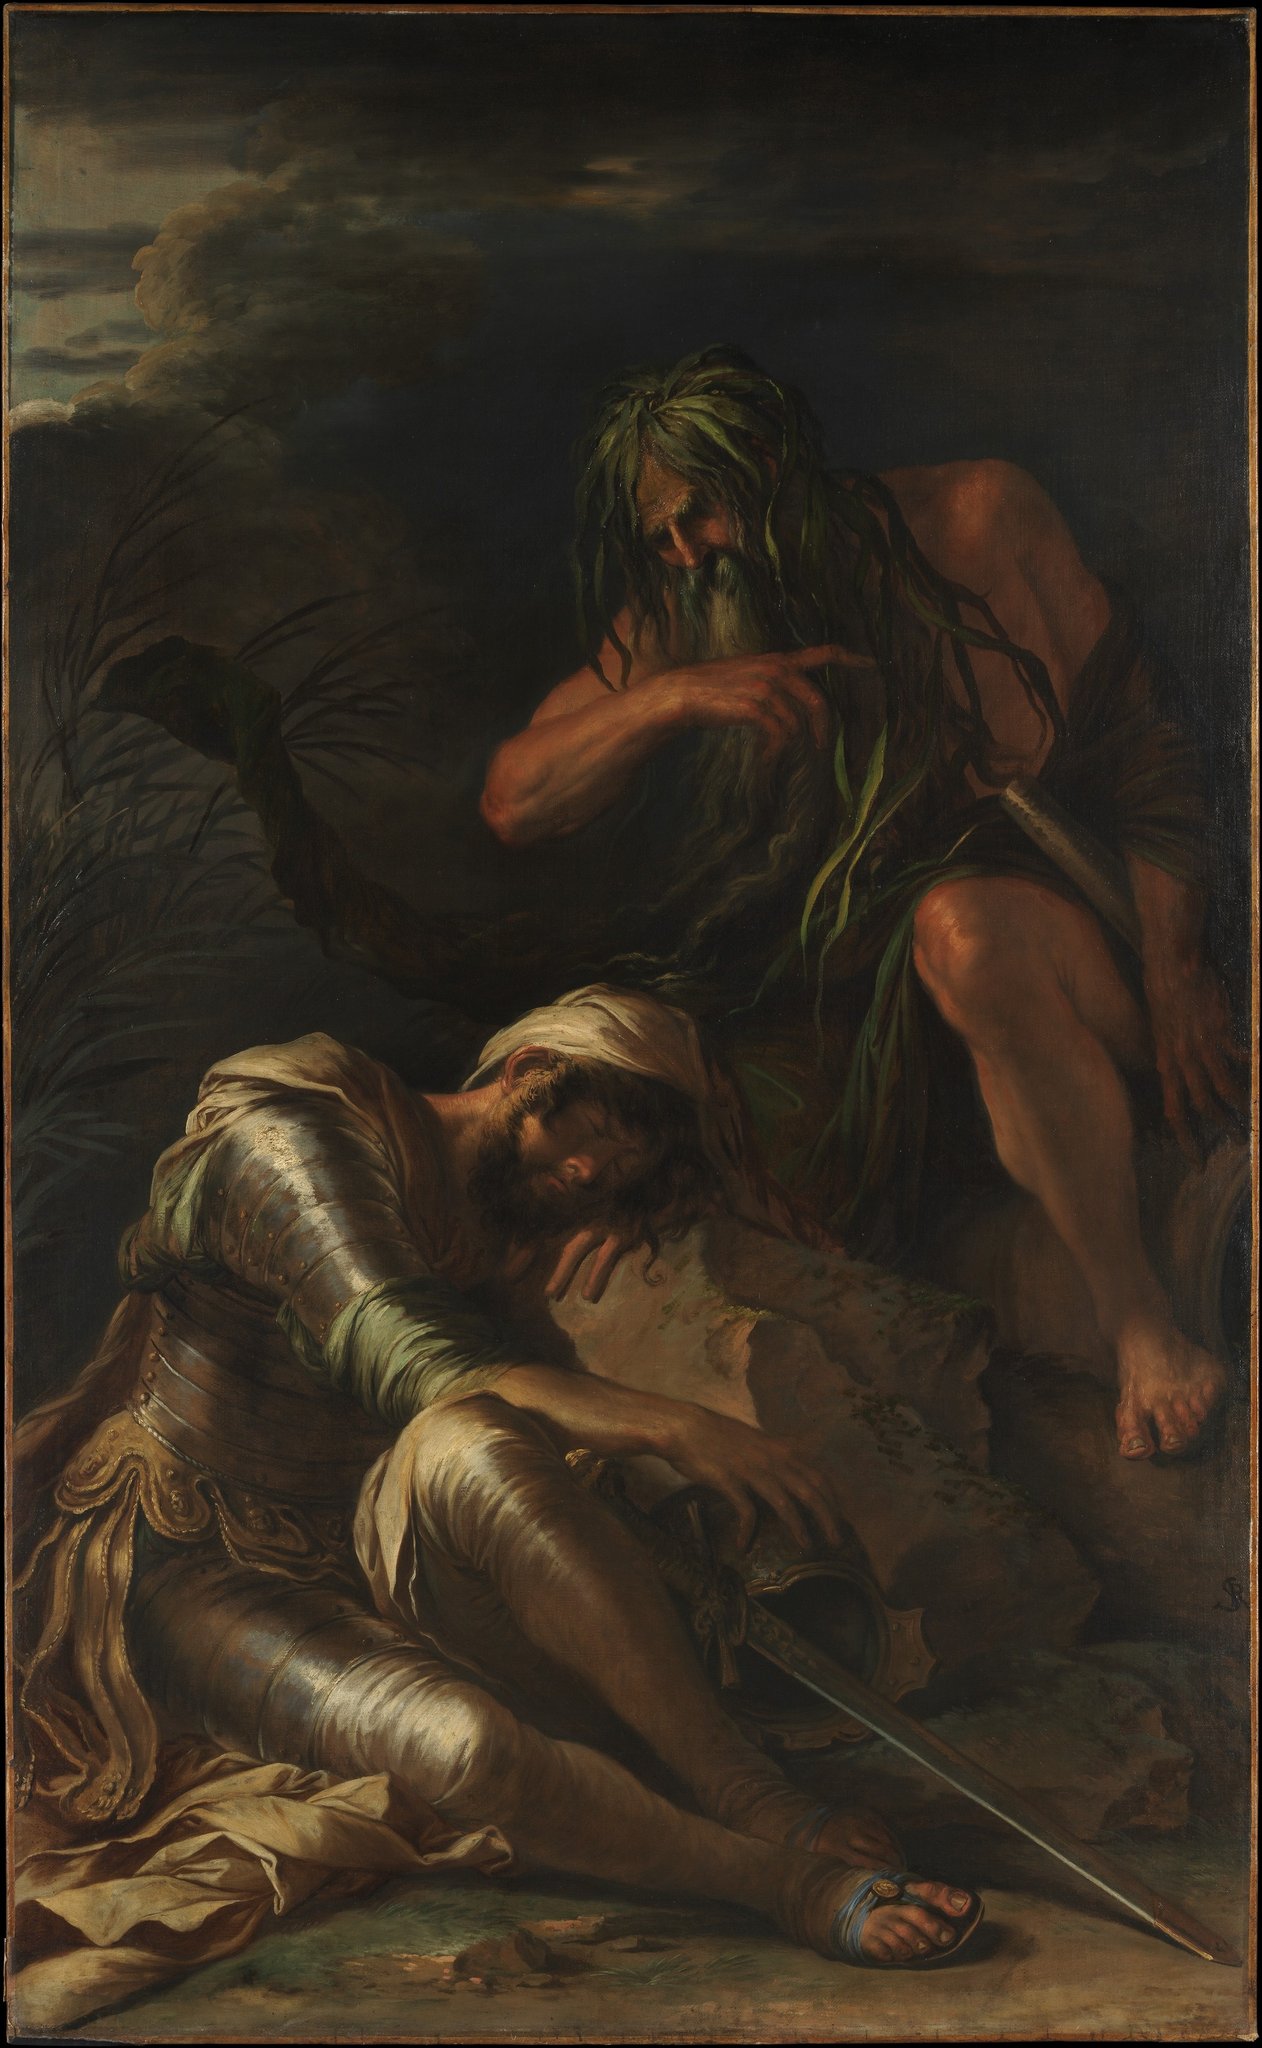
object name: painting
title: The Dream of Aeneas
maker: salvator rosa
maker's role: artist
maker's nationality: italian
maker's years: 1615-1673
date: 1660-1665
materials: canvas, oil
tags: swords,sleeping,men,aeneas,aeneid